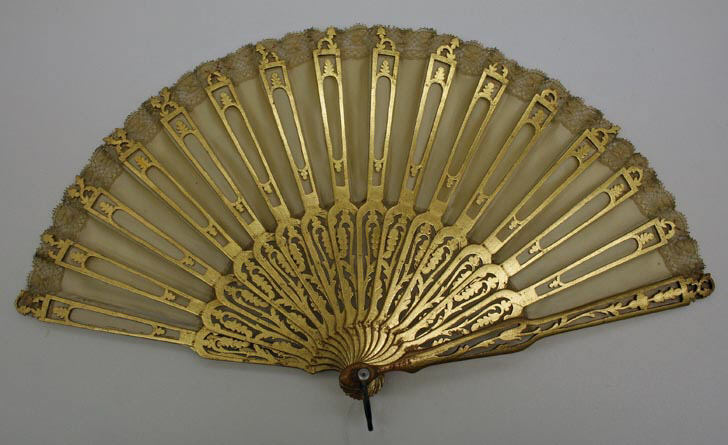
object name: fan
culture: american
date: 1870-1879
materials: silk